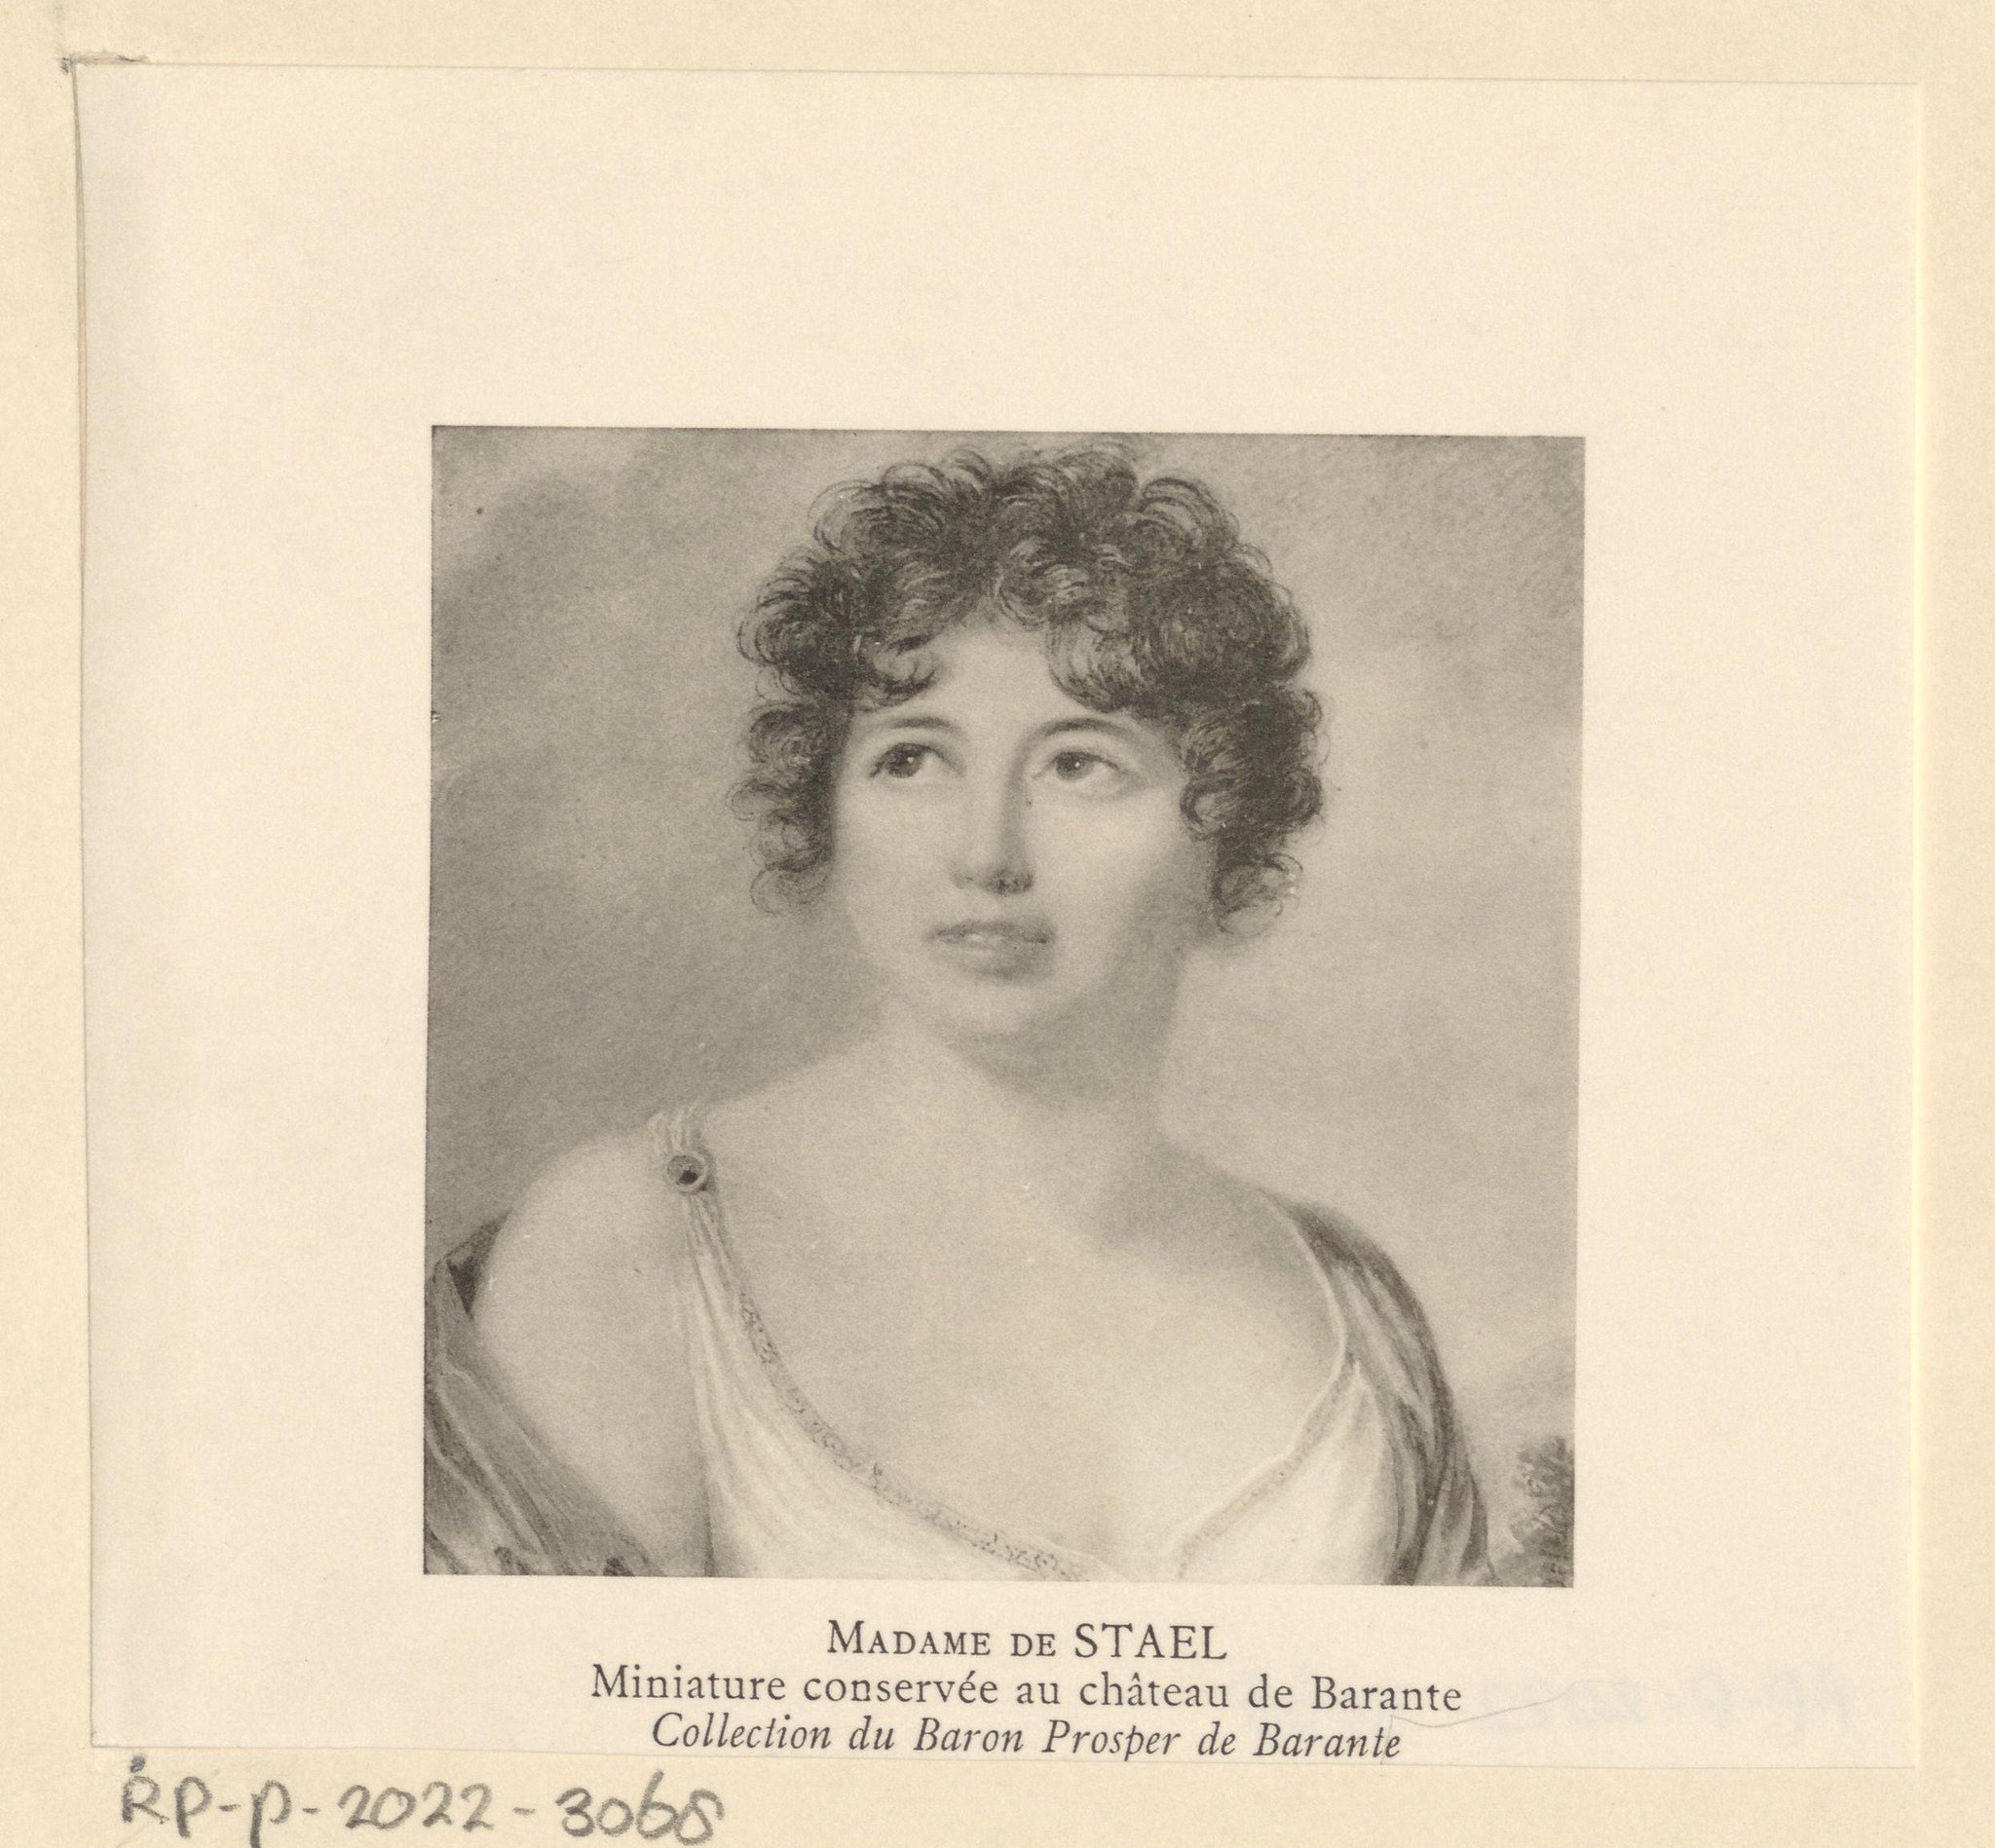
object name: photomechanical print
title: Portret van Anne-Louise Germain Necker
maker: Anonymous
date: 1875-1930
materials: paper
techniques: photograph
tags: paris, historical persons - bb - woman, portrait of a writer